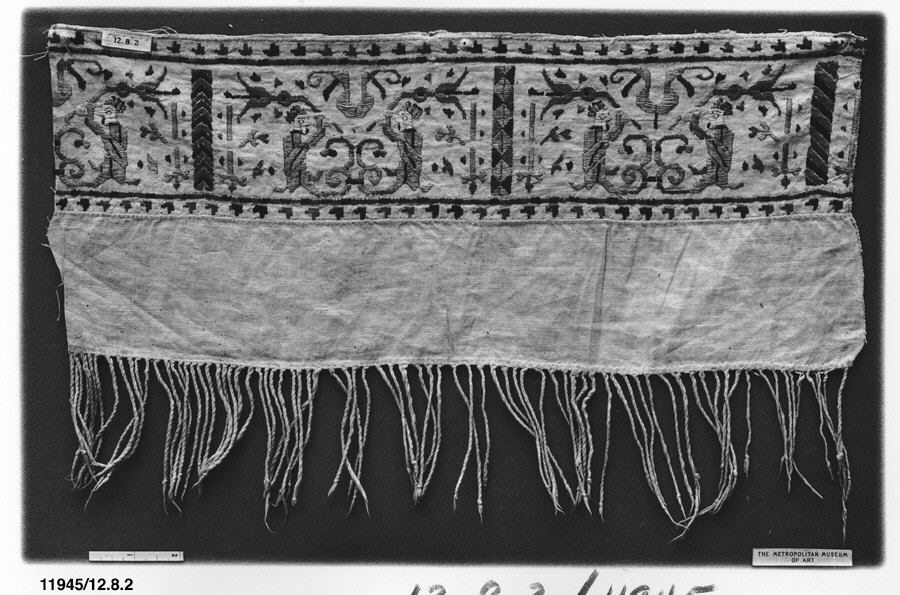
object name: towel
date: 1601-1700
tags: human figures